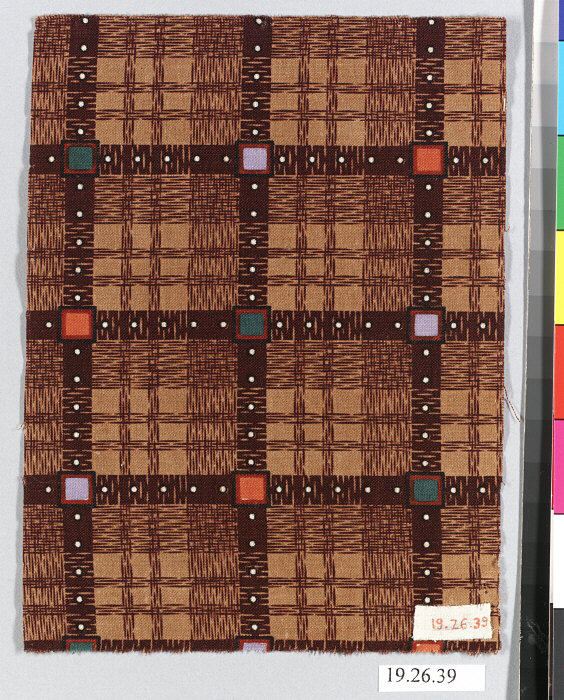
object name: sample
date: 1840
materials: cotton